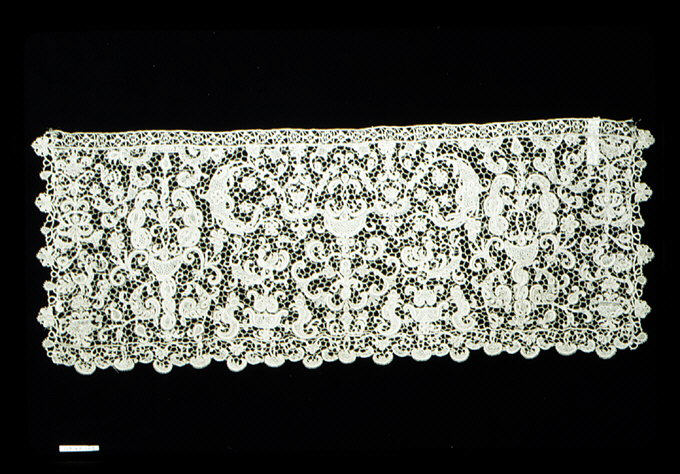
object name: cravat end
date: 1667-1700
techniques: lace